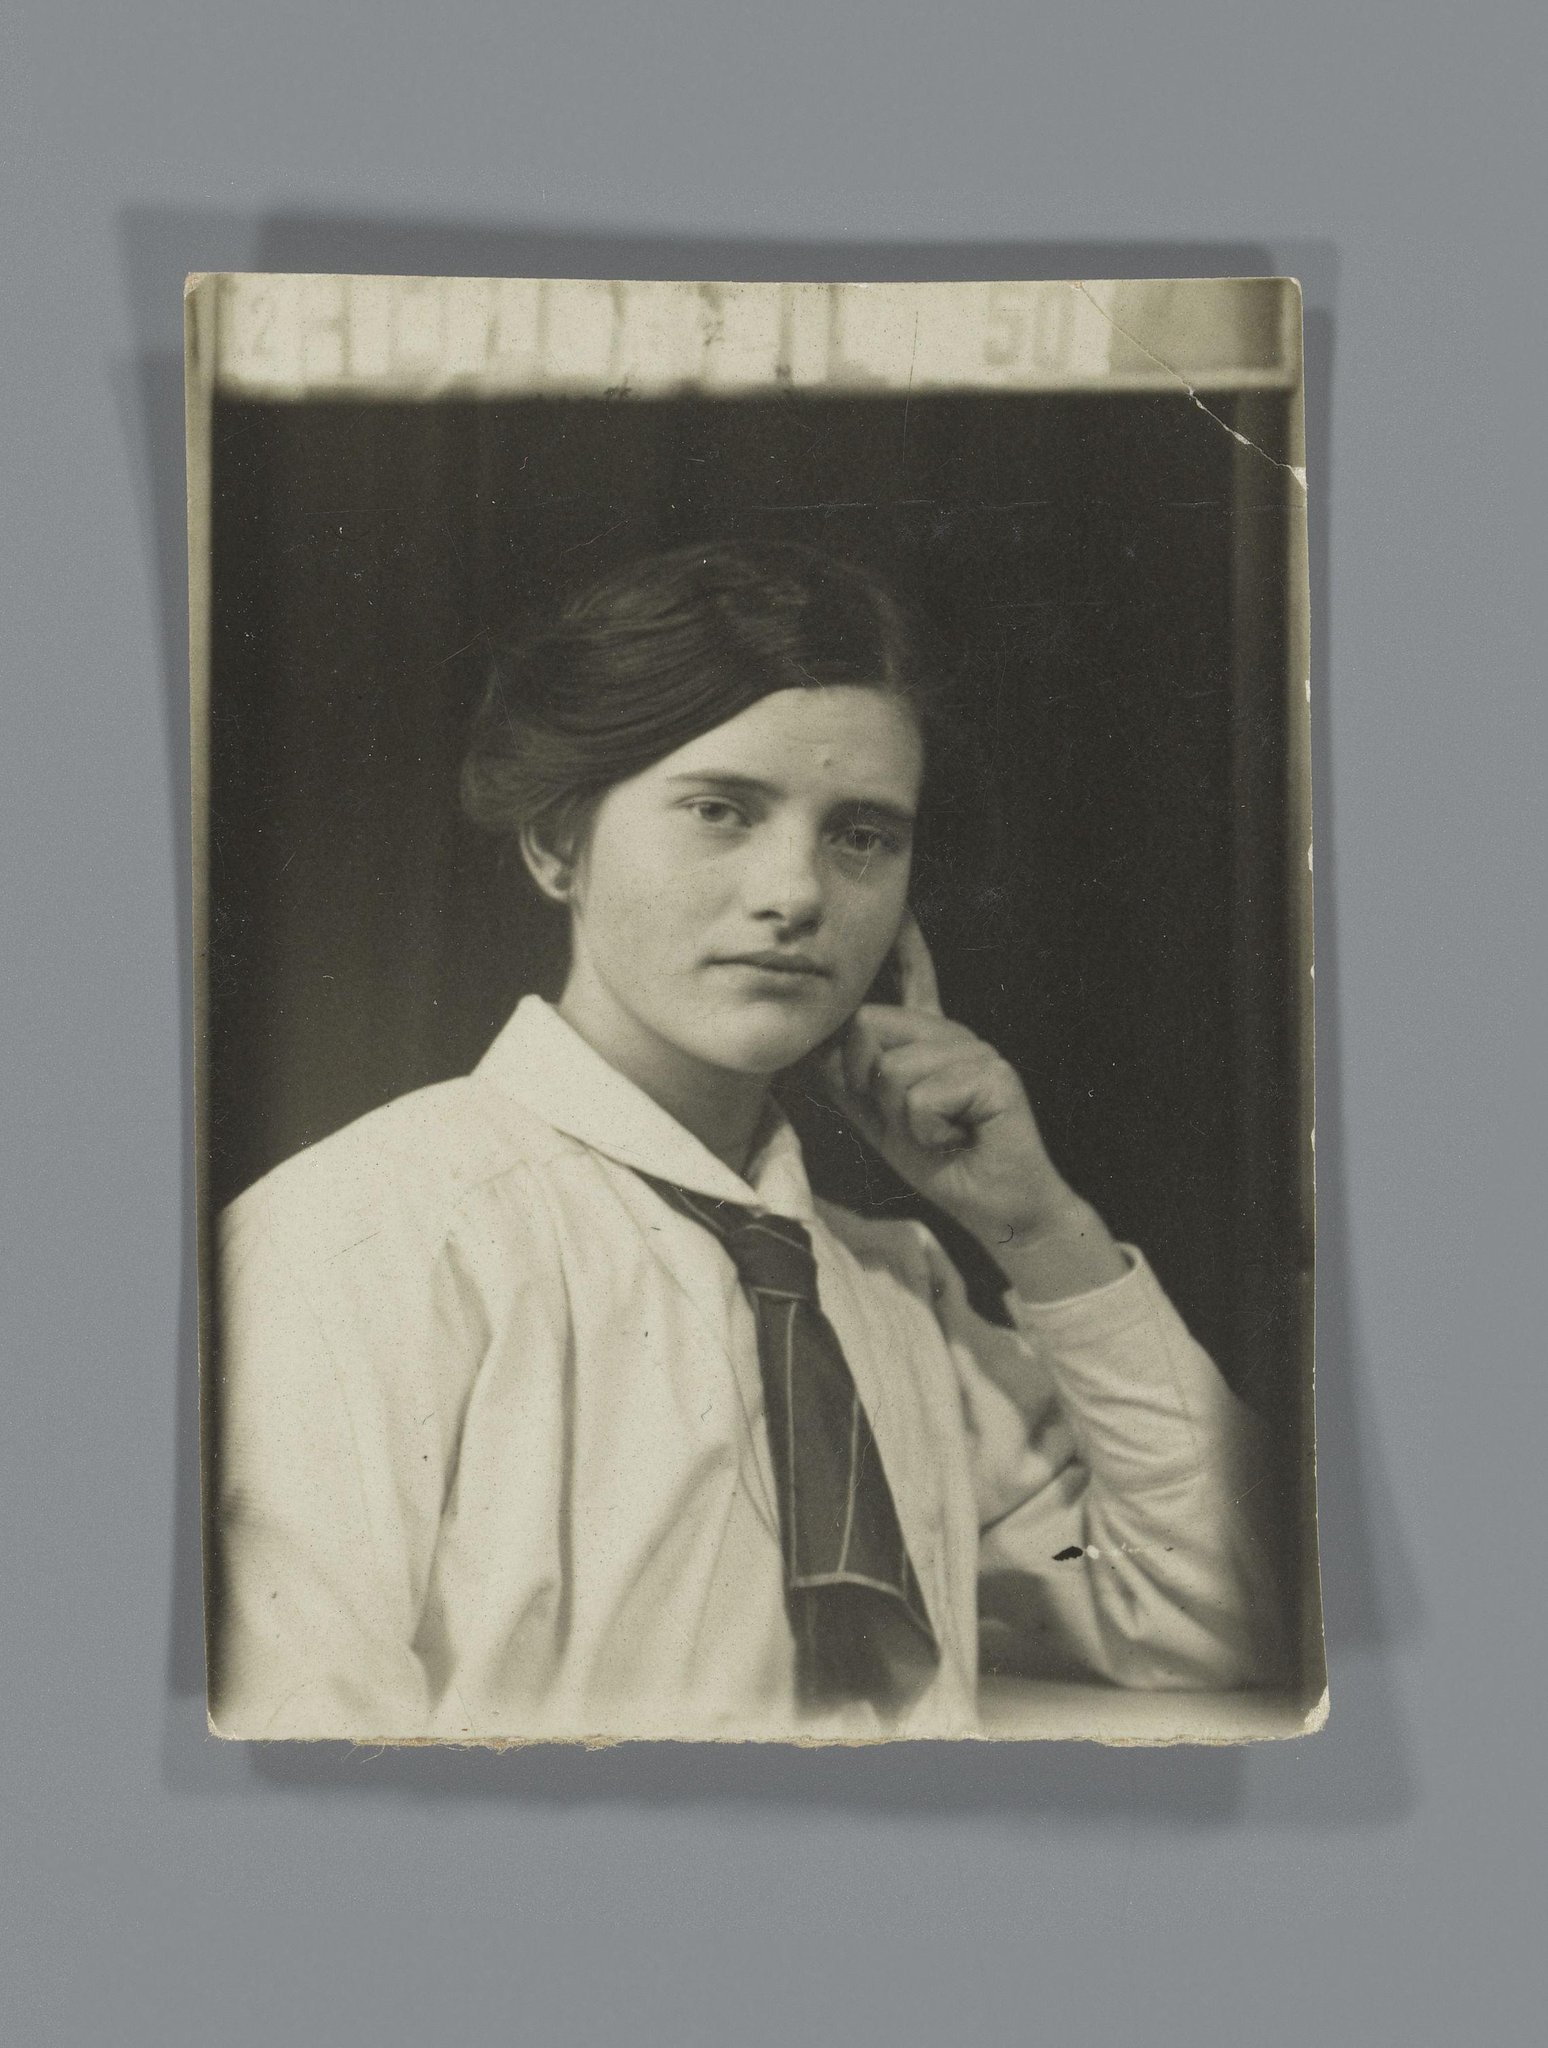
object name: snapshot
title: Rapid photographs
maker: jan gottfried stütner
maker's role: fotograaf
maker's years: 1892-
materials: photographic support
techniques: gelatin silver print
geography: alkmaar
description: Between 1912 and 1930, anyone could have their portrait taken at the many so-called rapid photography studios in the shopping streets of mainly (medium) large-size European cities. As if on an assembly line, the youngest clerk shot the photographs with a special camera and in artificial light and developed them. Later in the day, the customer collected a sheet with 12 portrait photos for 25 cents. This form of photographic mass production gave rise to a fascinating tableau of boys, girls, men and women not previously seen in photographs; candid and informal. There were at least 150 quick-photo studios, from Alkmaar to Zutphen. Many called themselves ‘American,’ mistakenly as it turns out because hardly any examples from that country have been found.